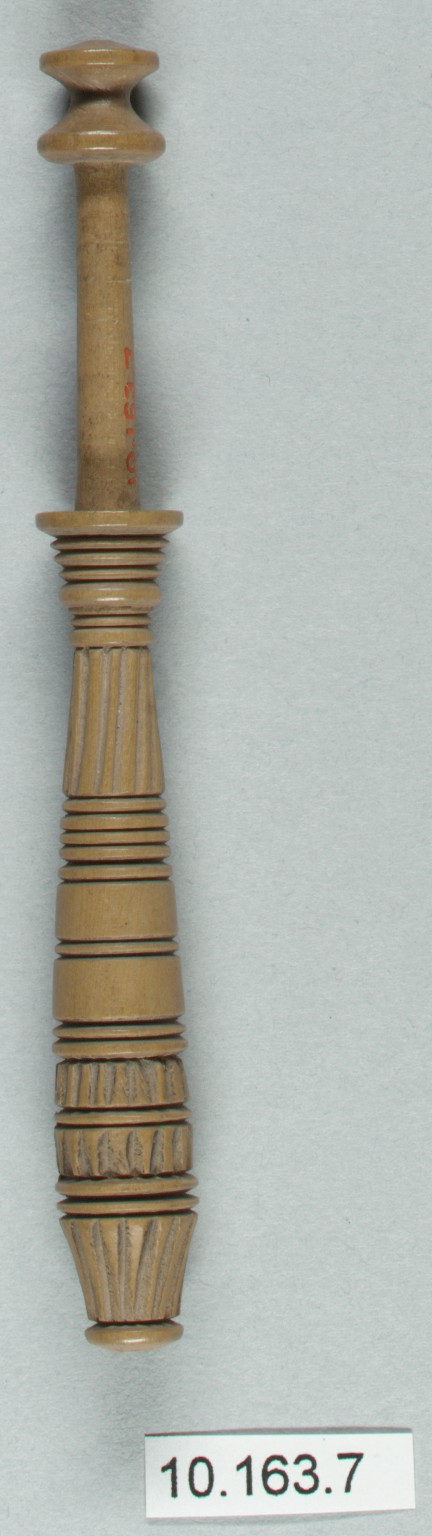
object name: bobbin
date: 1801-1900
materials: wood